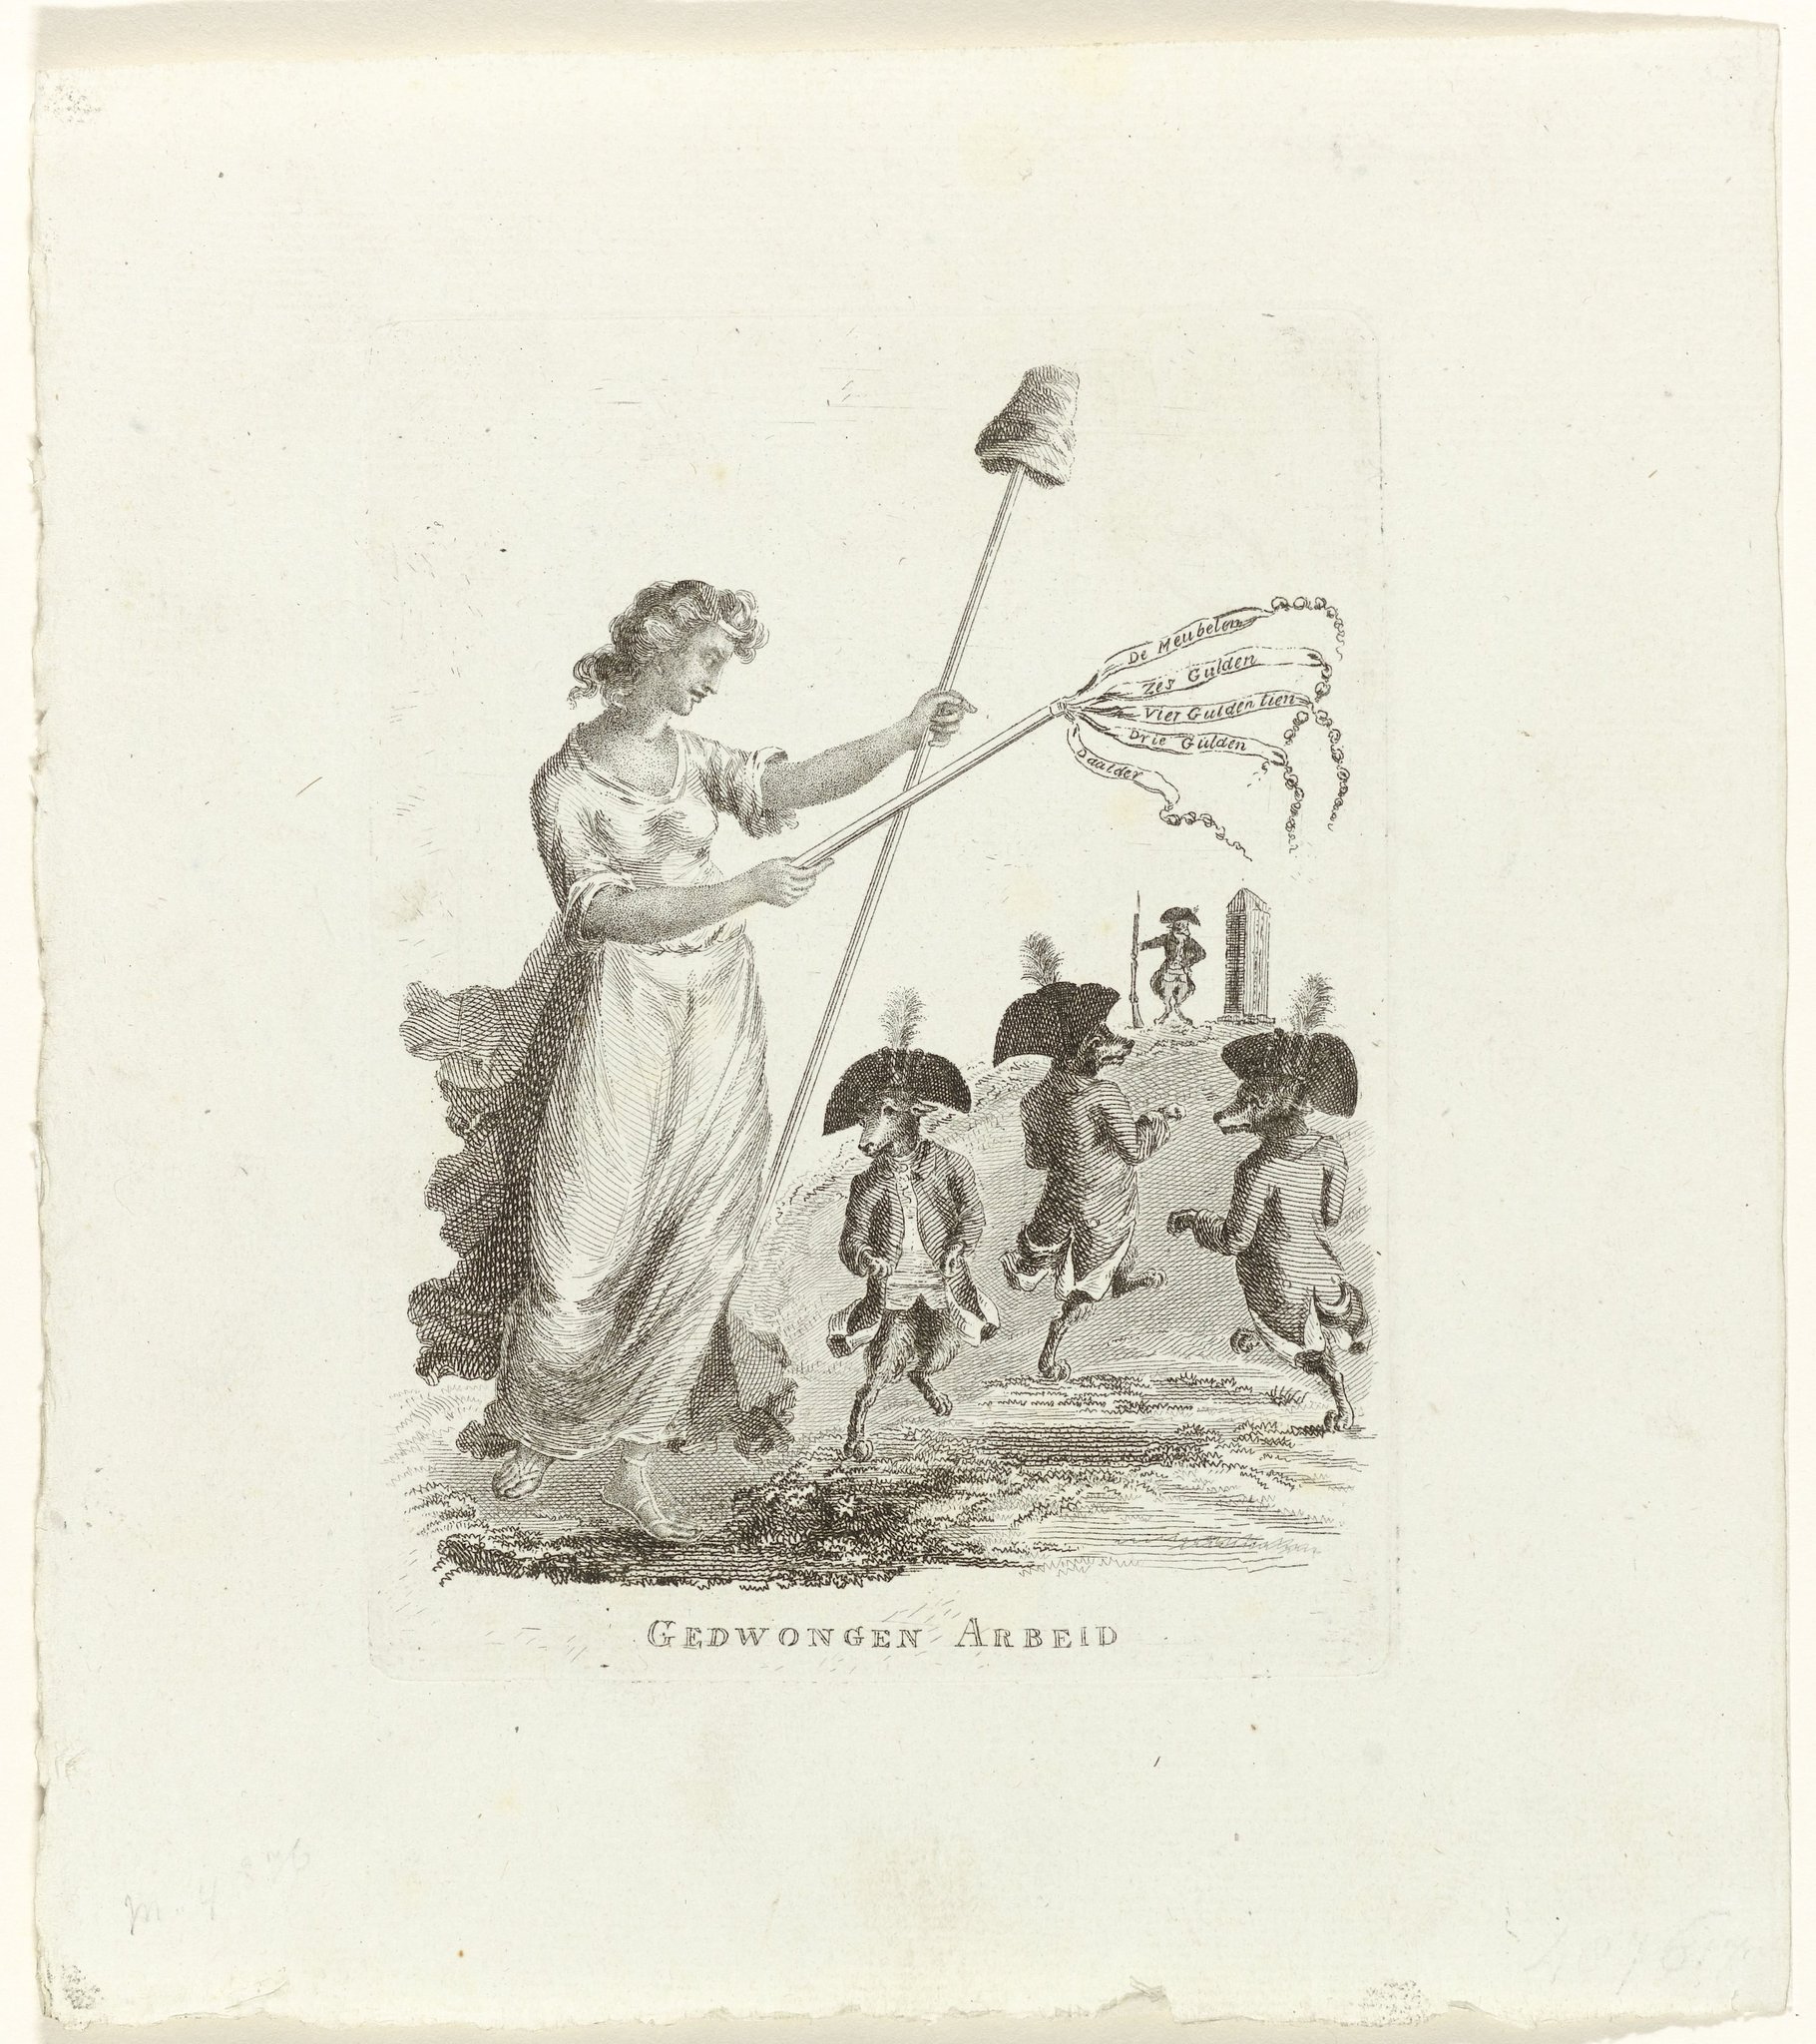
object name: cartoon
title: Gedwongen Arbeid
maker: Anonymous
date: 1787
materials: paper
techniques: engraving, etching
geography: northern netherlands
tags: training of performing dog, animals acting as human beings, freedom, liberty; 'libertà' (ripa) (+ abstract concept represented by female figure), patriots (1780-1795)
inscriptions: inscription: ‘1/2 maart 1787’, collector's mark: Lugt 2228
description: Spotprent waarin de Nederlandse Vrijheid drie patriotten als keeshonden met een karwats dresseert om een dansje te maken. Naar aanleiding van de politieke toestand in 1787.